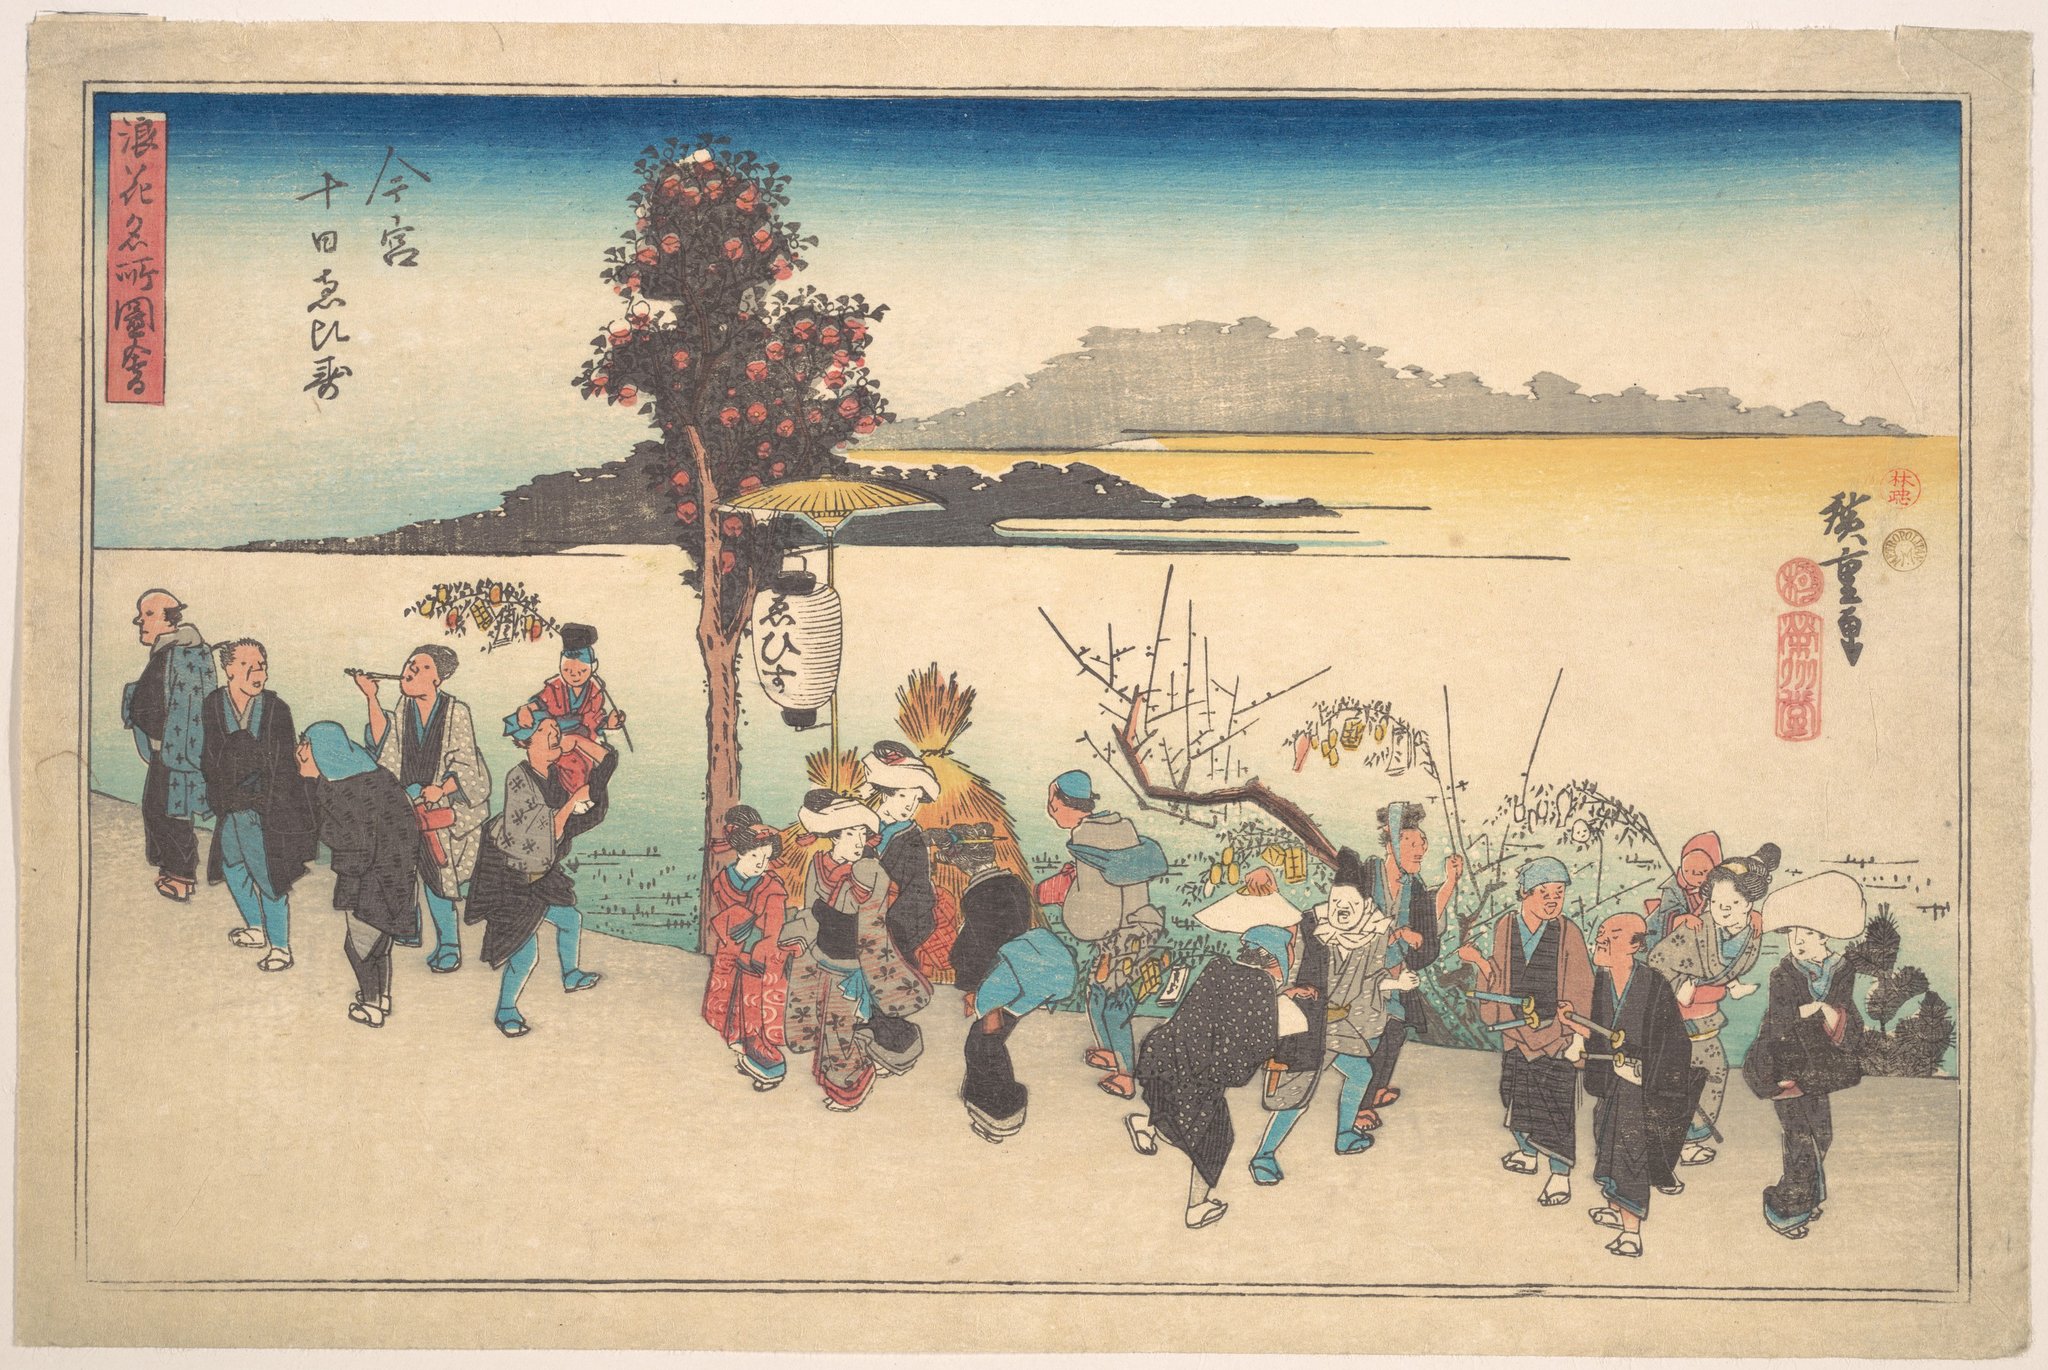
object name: print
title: Imamiya Toka Ebisu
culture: japanese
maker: utagawa hiroshige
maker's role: artist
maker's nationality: japanese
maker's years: 1797-1858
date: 1828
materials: ink, paper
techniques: woodblock print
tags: human figures,roads,trees,lanterns